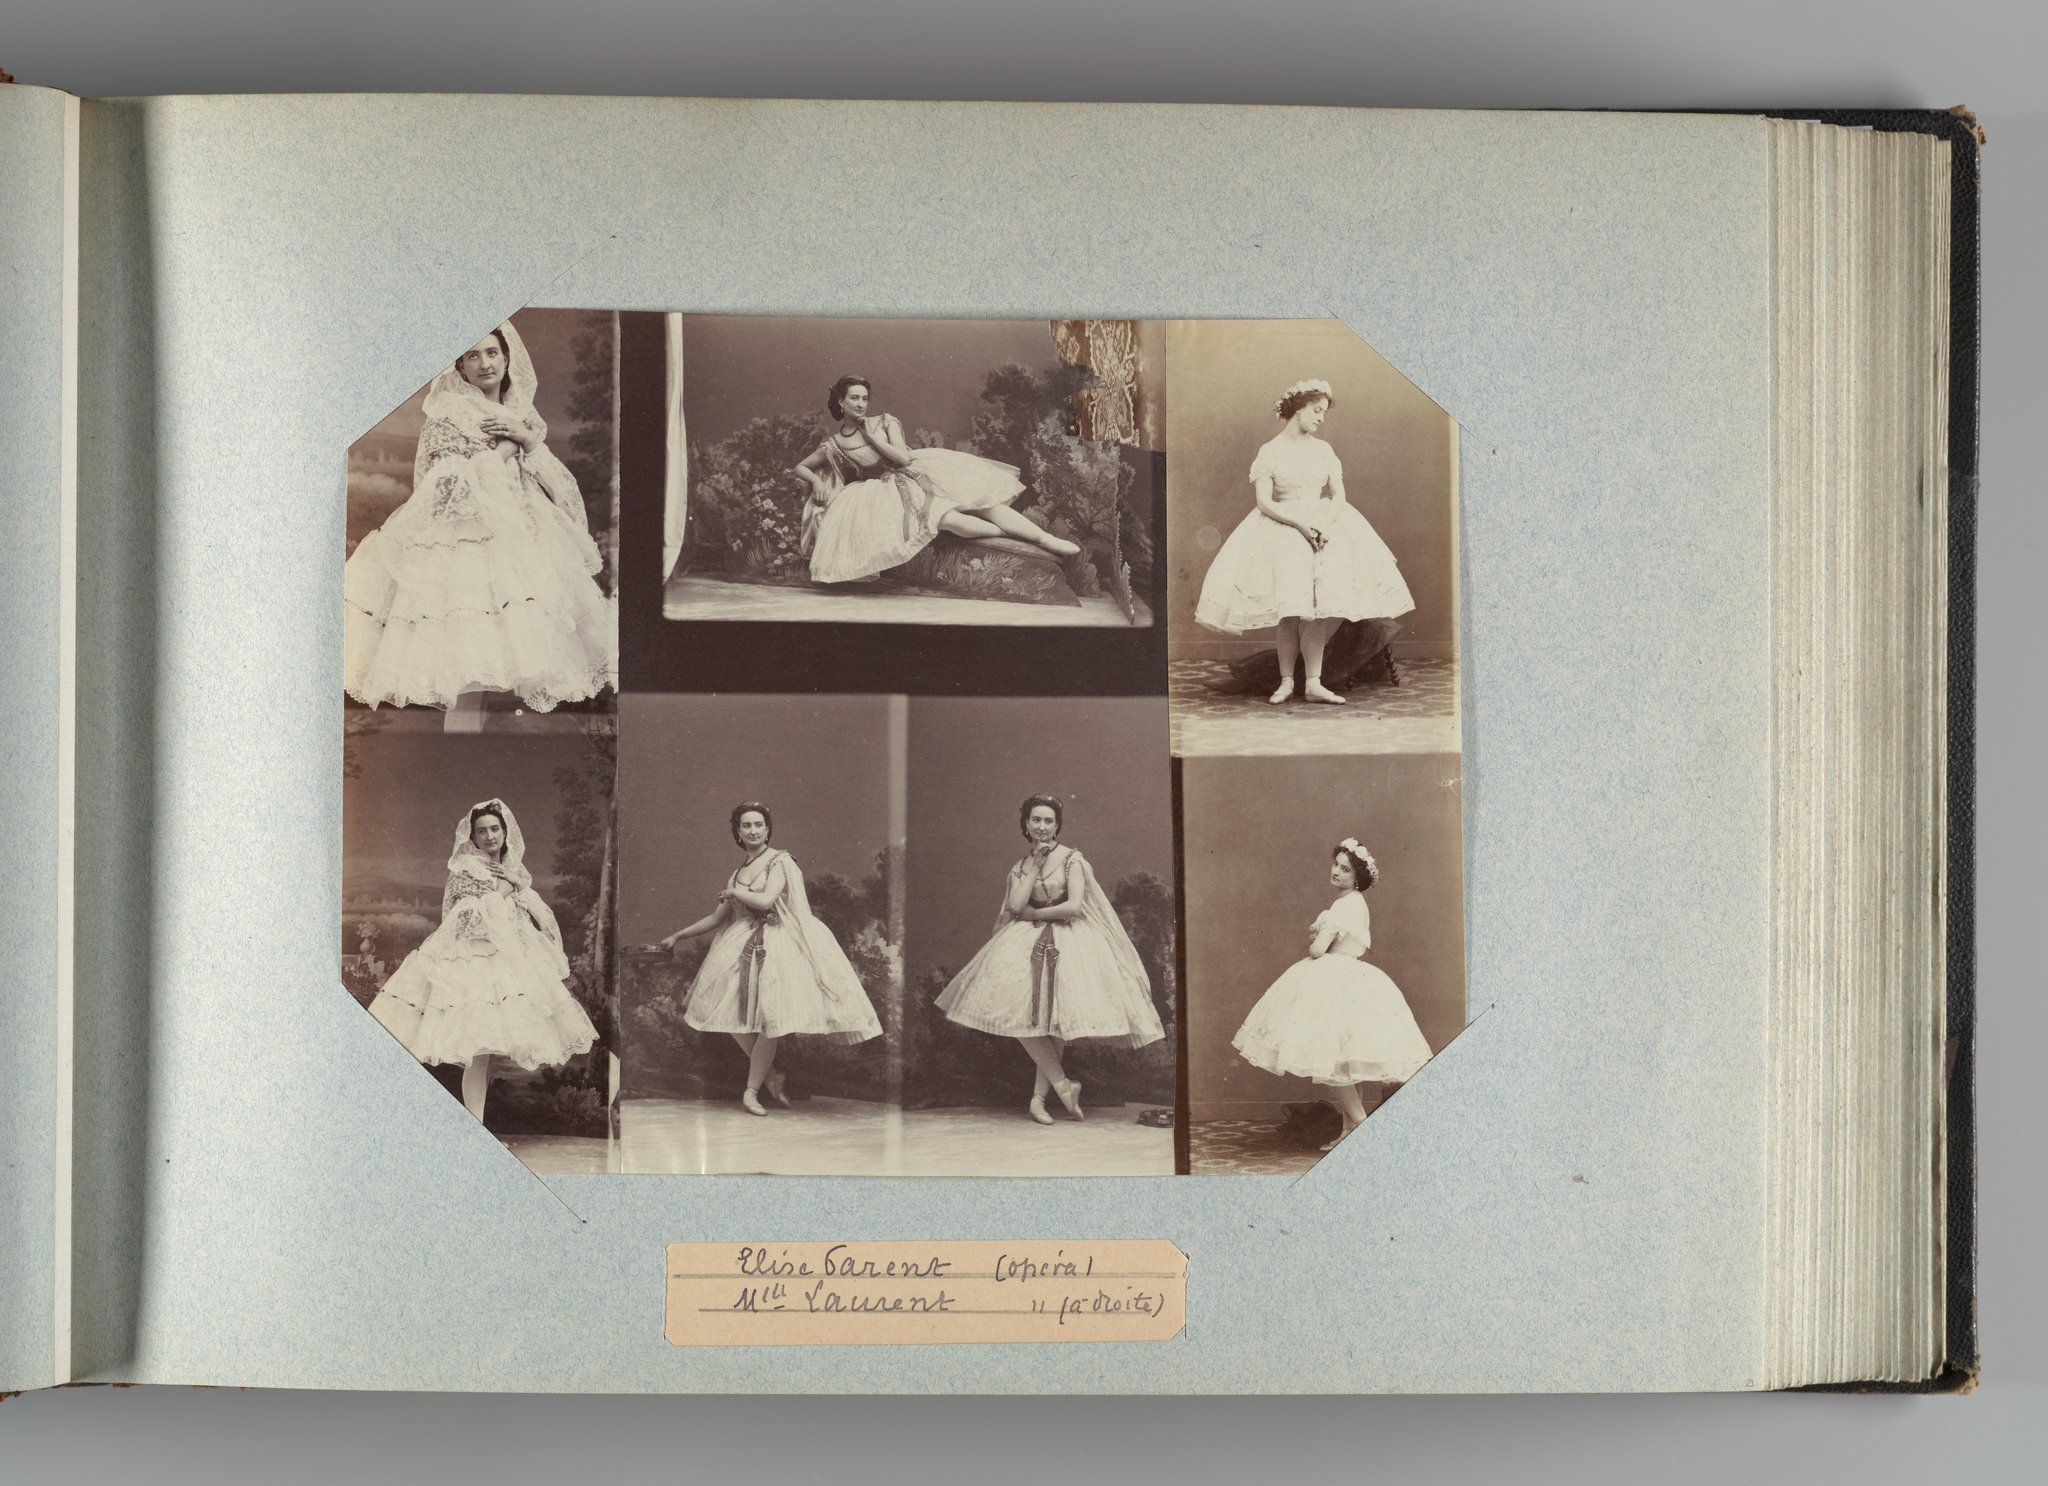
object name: photograph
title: Elisa Parent; Mlle Laurent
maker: andré-adolphe-eugène disdéri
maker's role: artist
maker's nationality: french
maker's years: 1819-1889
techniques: albumen silver print, glass negative